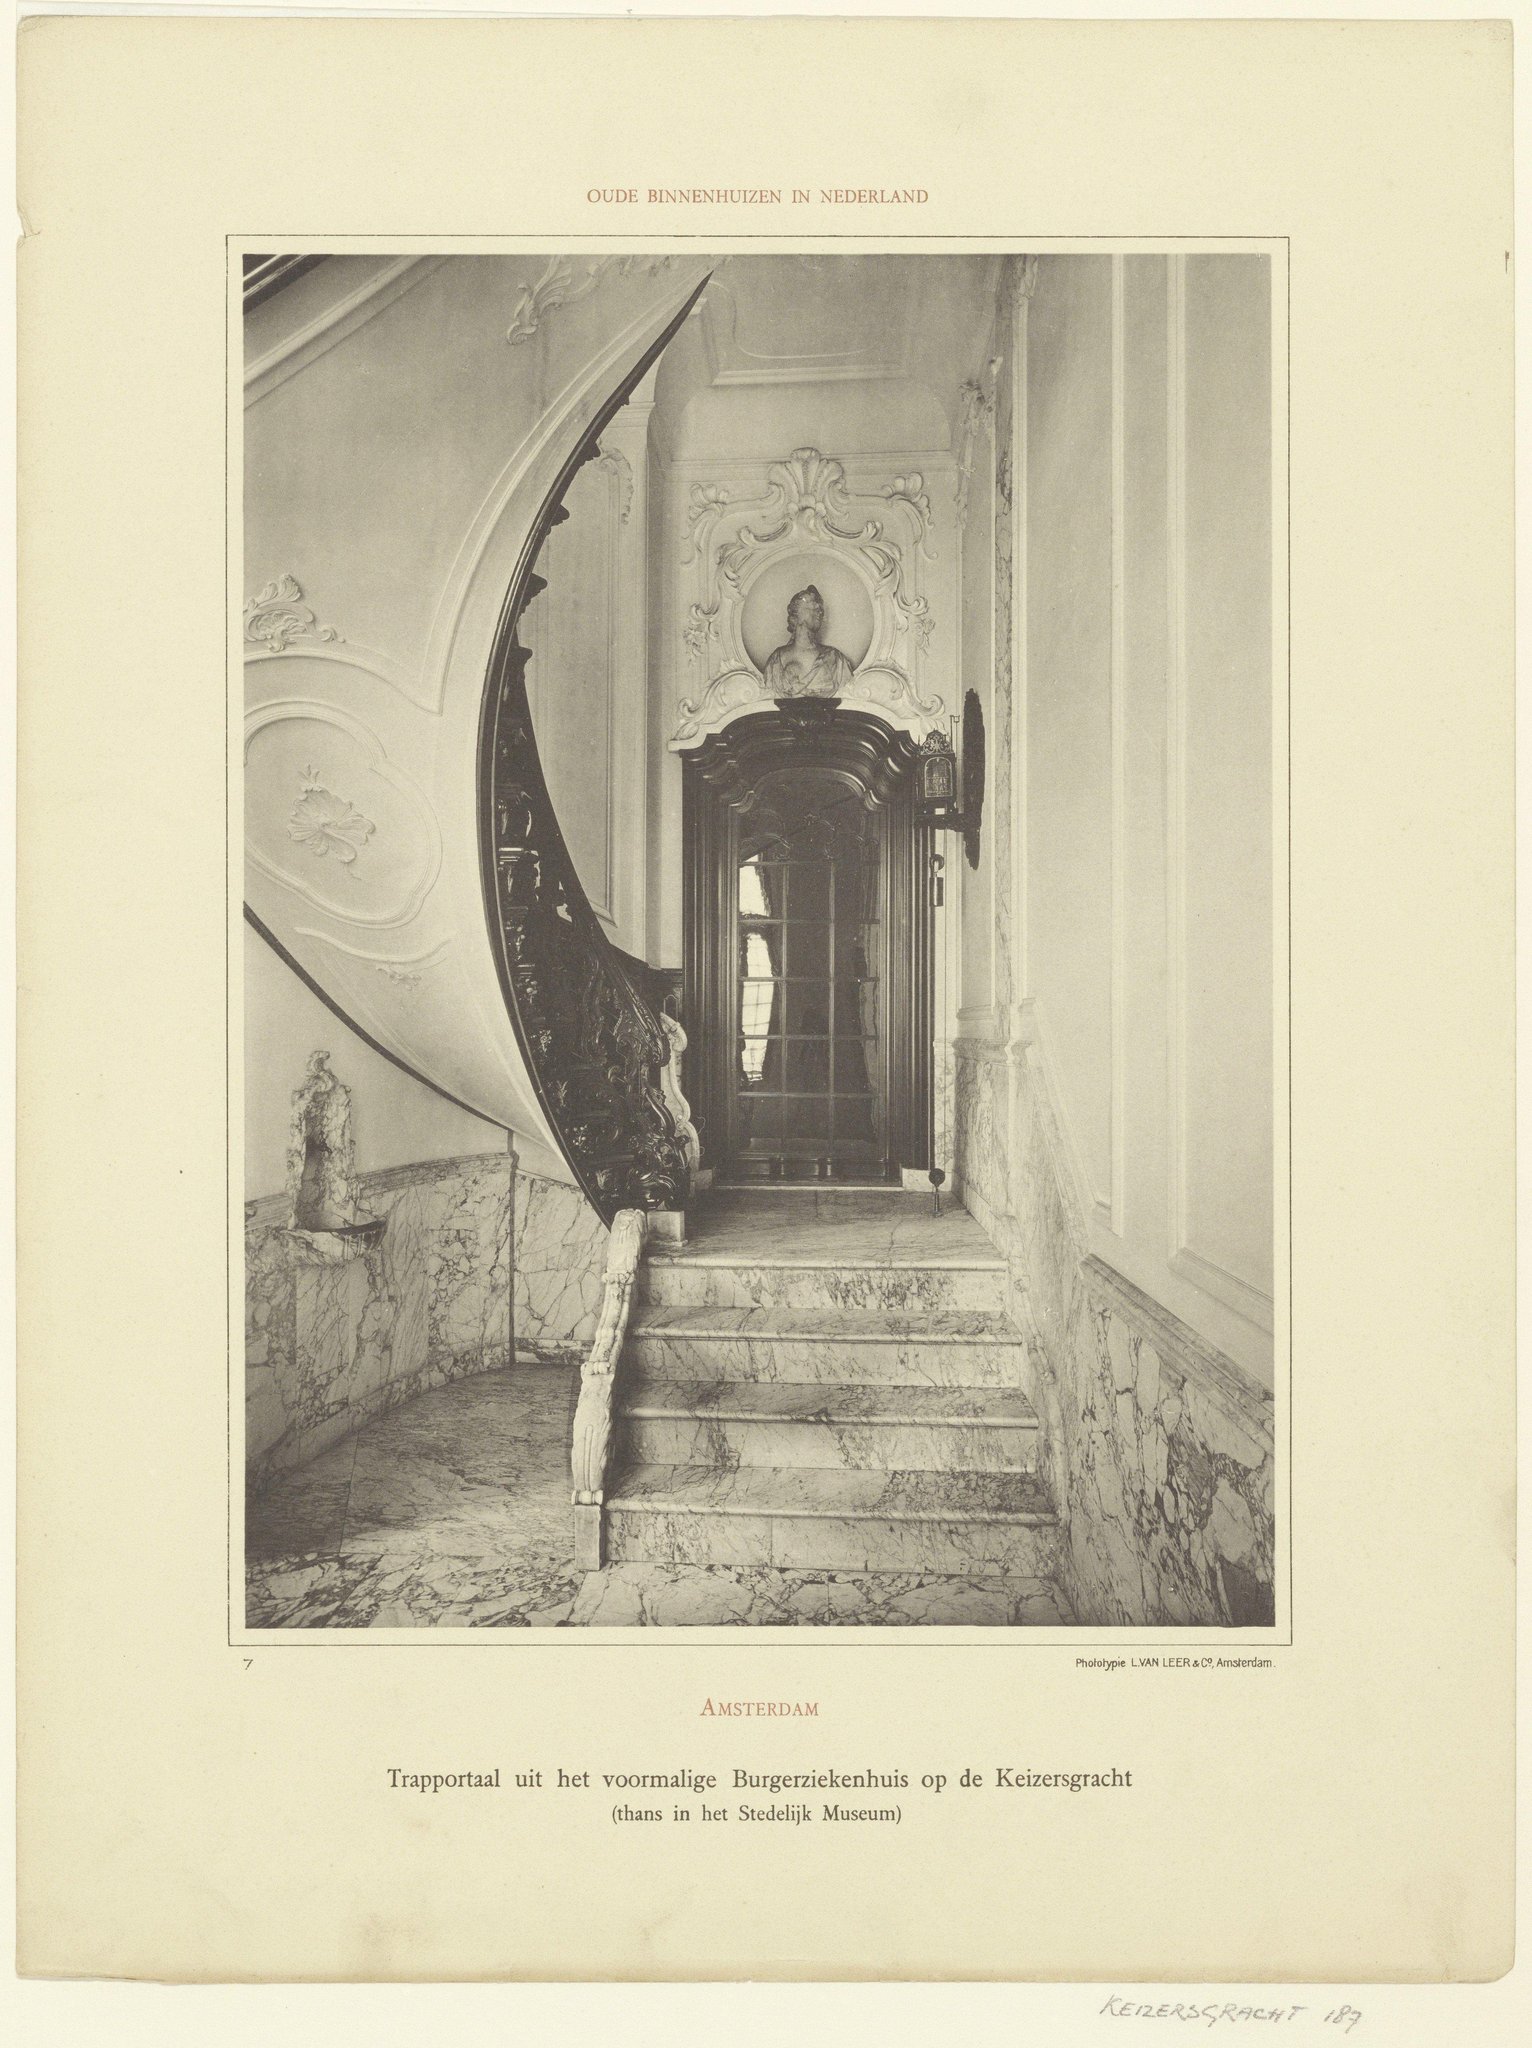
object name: spiral stair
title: Onderdelen van het trapportaal uit het pand aan de Keizersgracht 187 te Amsterdam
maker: Anonymous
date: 1740-1760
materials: wood, marble